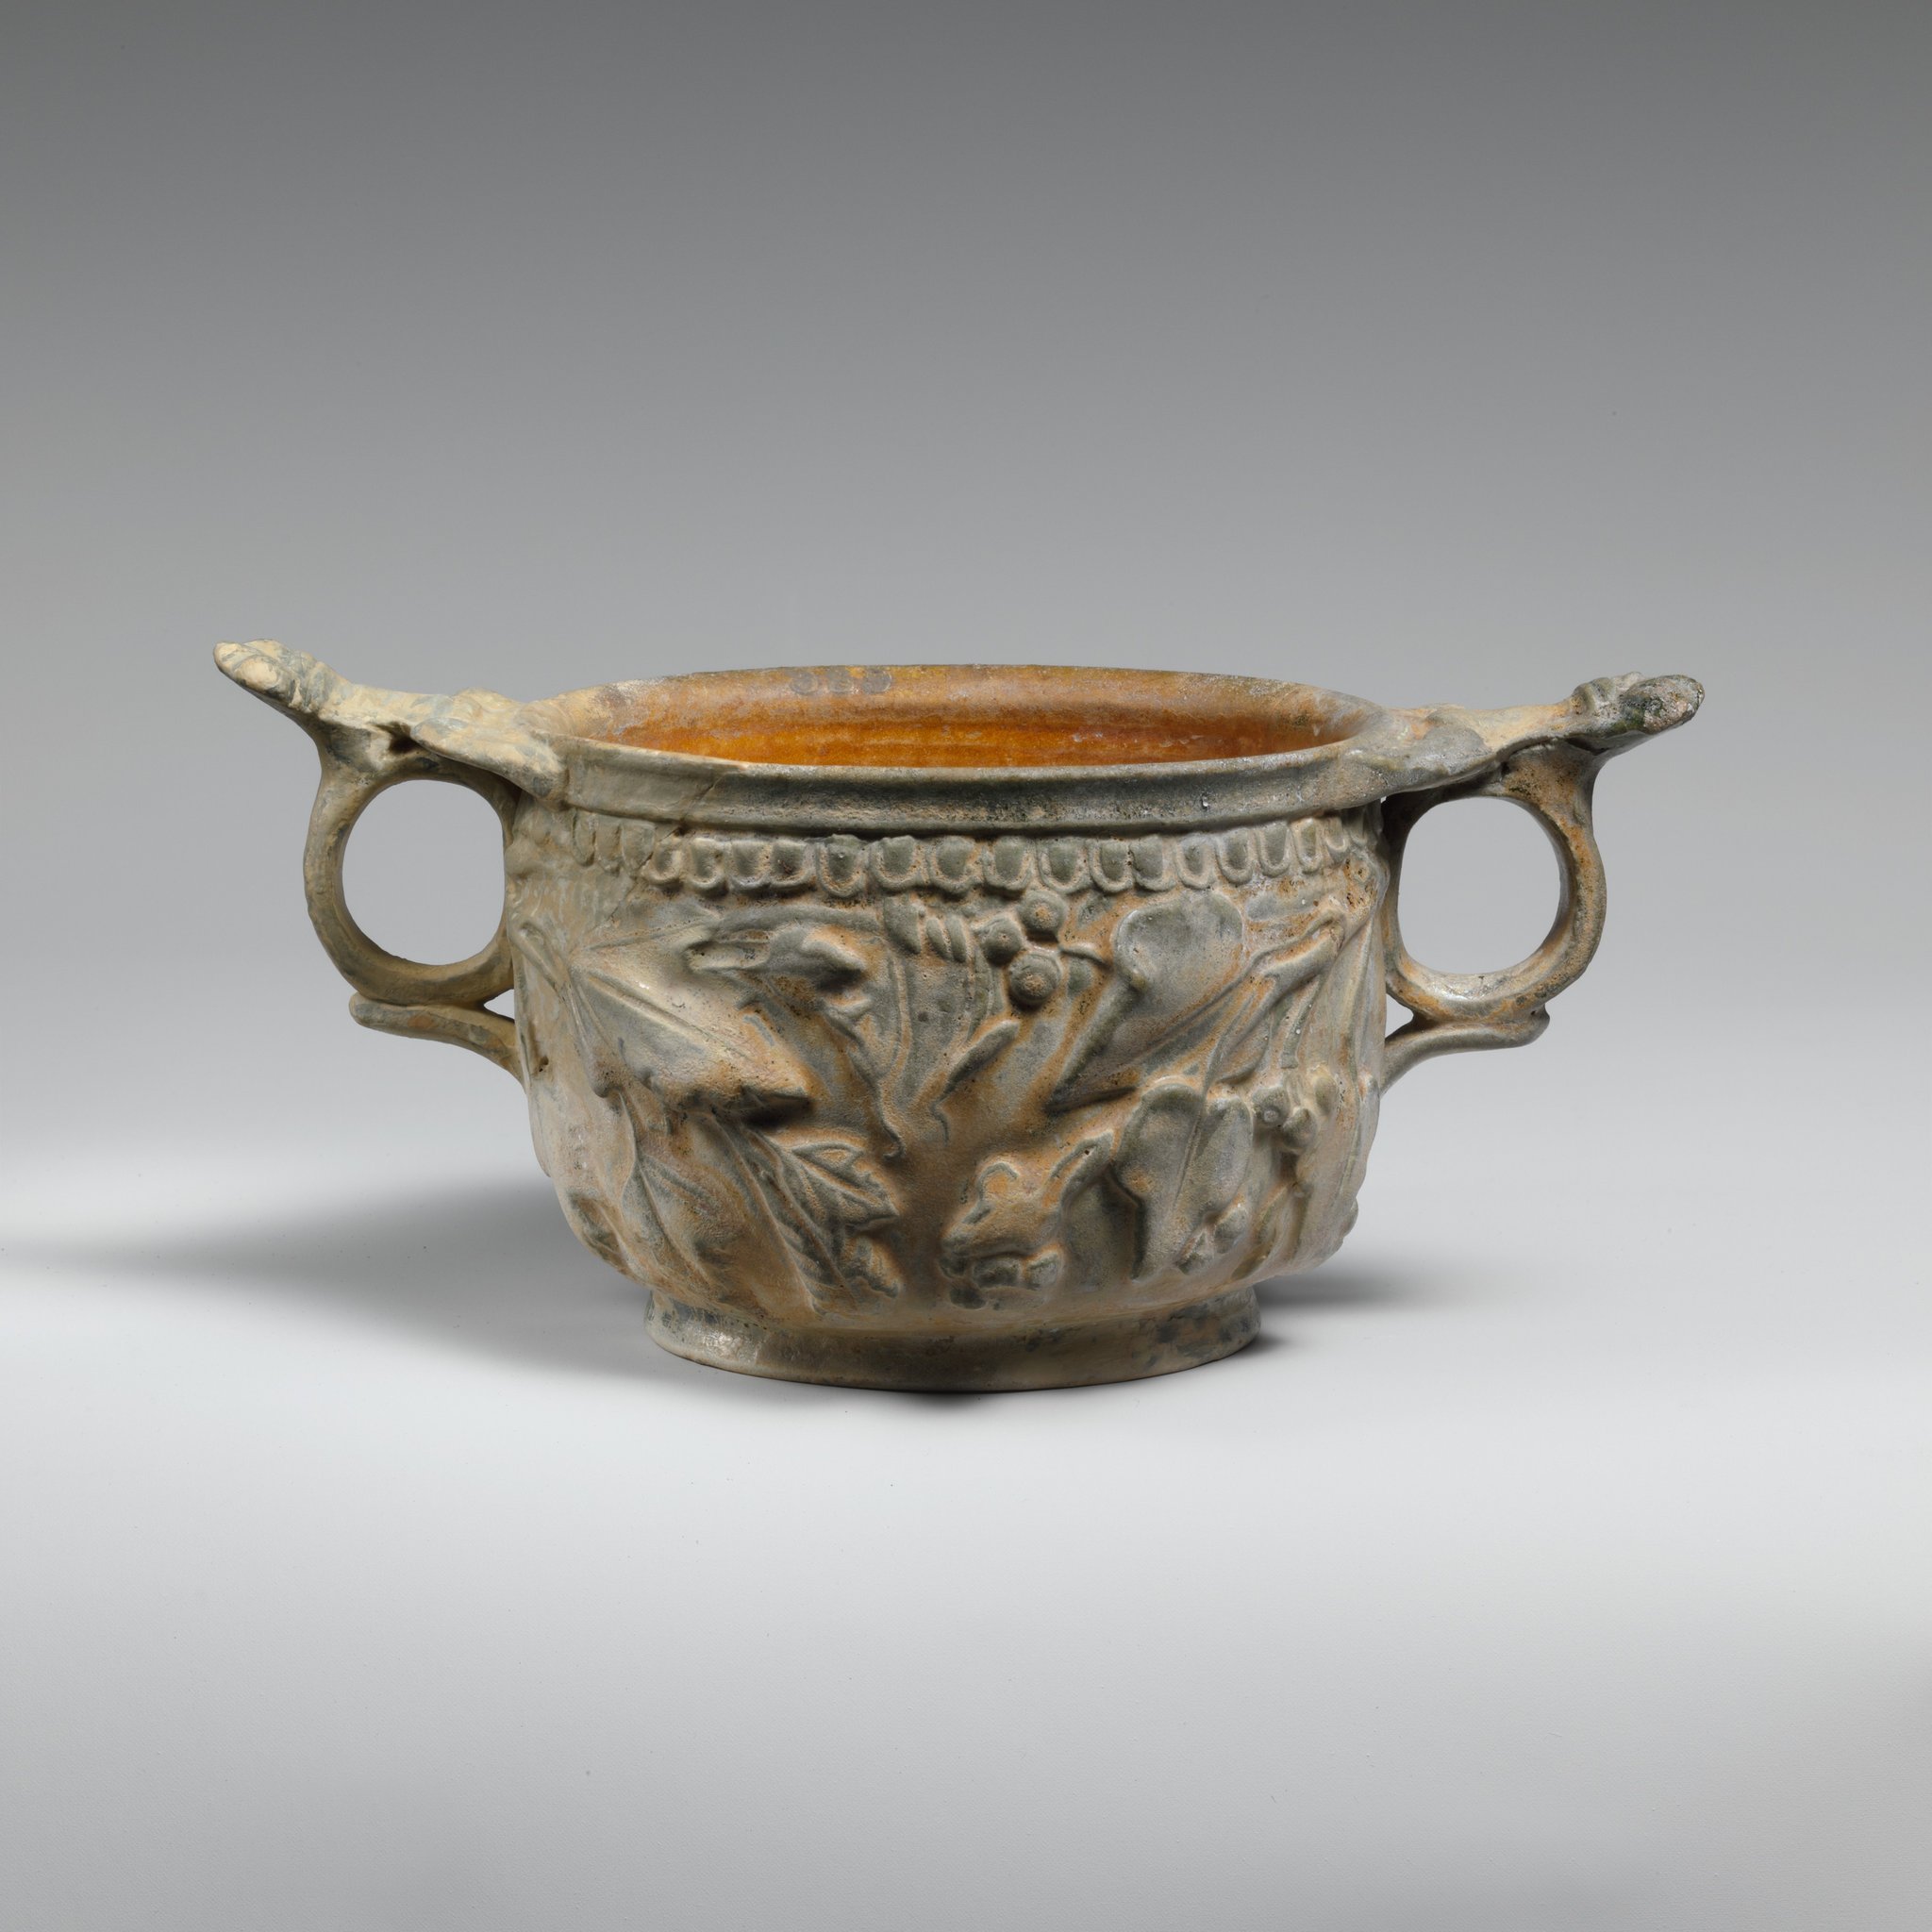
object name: skyphos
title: Terracotta lead-glazed scyphus (drinking cup)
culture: roman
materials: terracotta